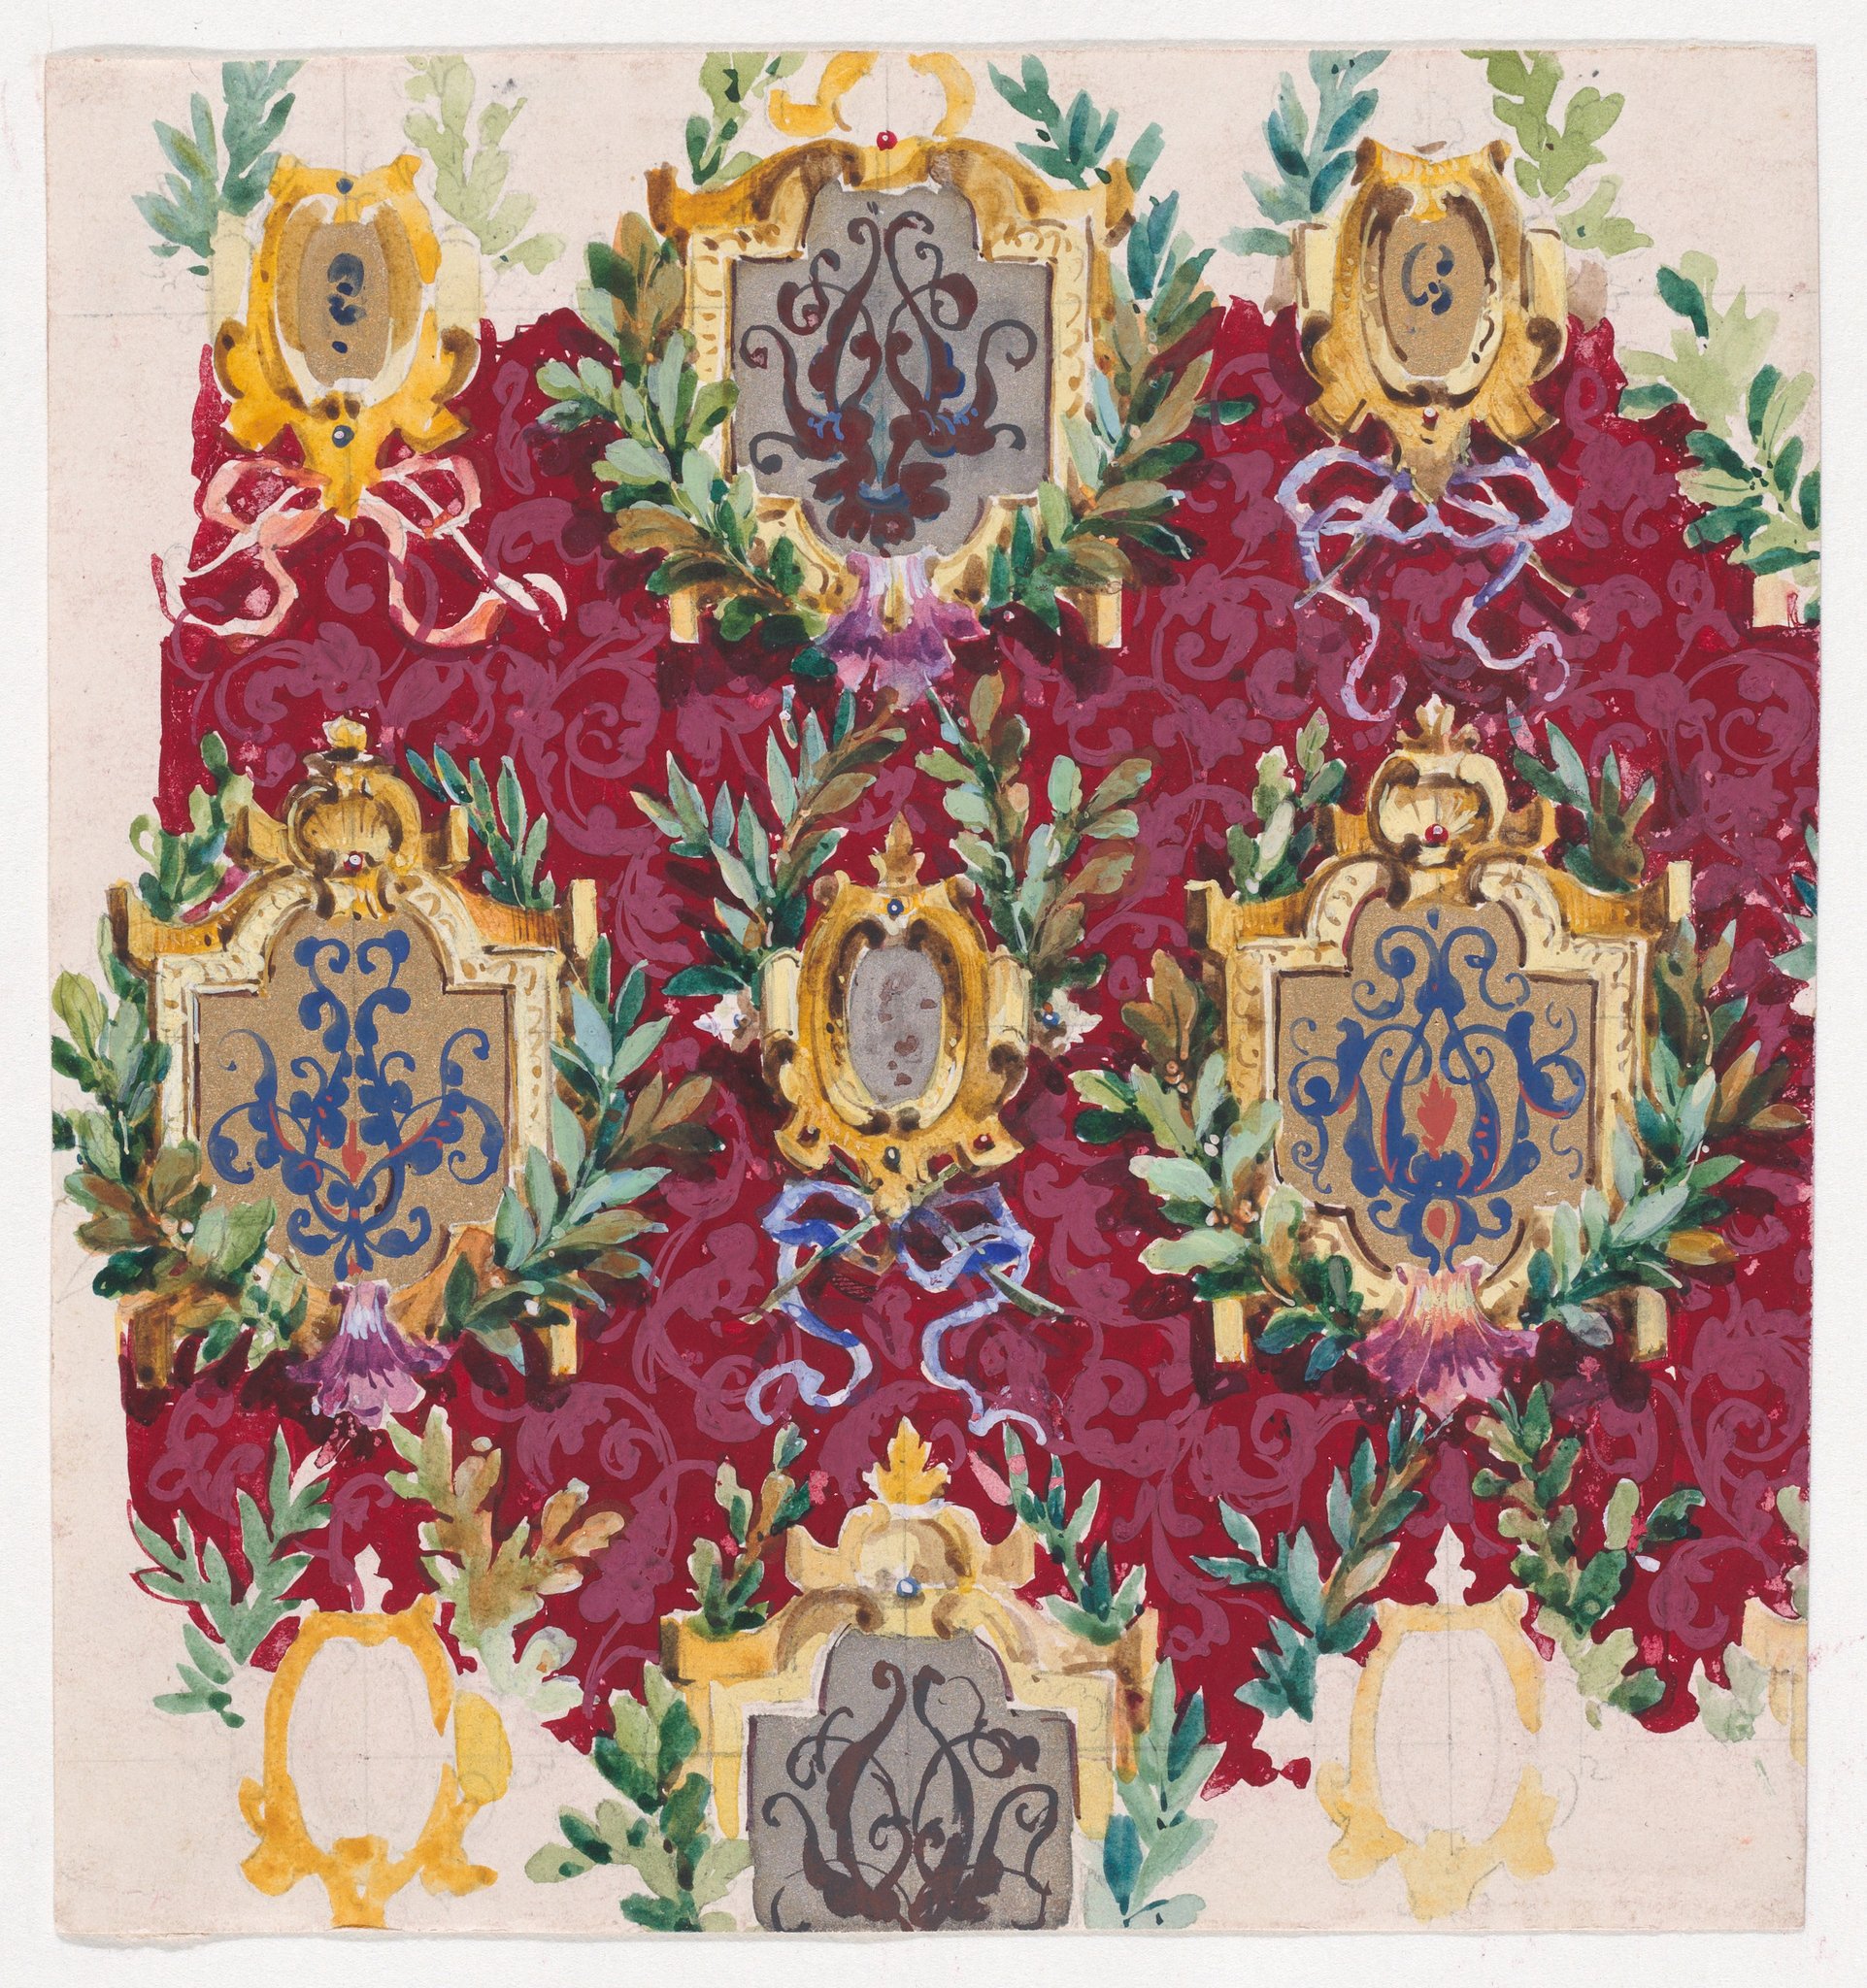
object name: drawing ornament architecture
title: Design for Wallpaper with Alternating Vertical Rows of Pairs of Ornamental Frames of Two Sizes Framed by Interlacing Garlands of Laurel Leaves Tied by a Bow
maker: anonymous, french, 19th century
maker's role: designer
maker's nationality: french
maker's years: 1800-1900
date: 1870-1900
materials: graphite, watercolor